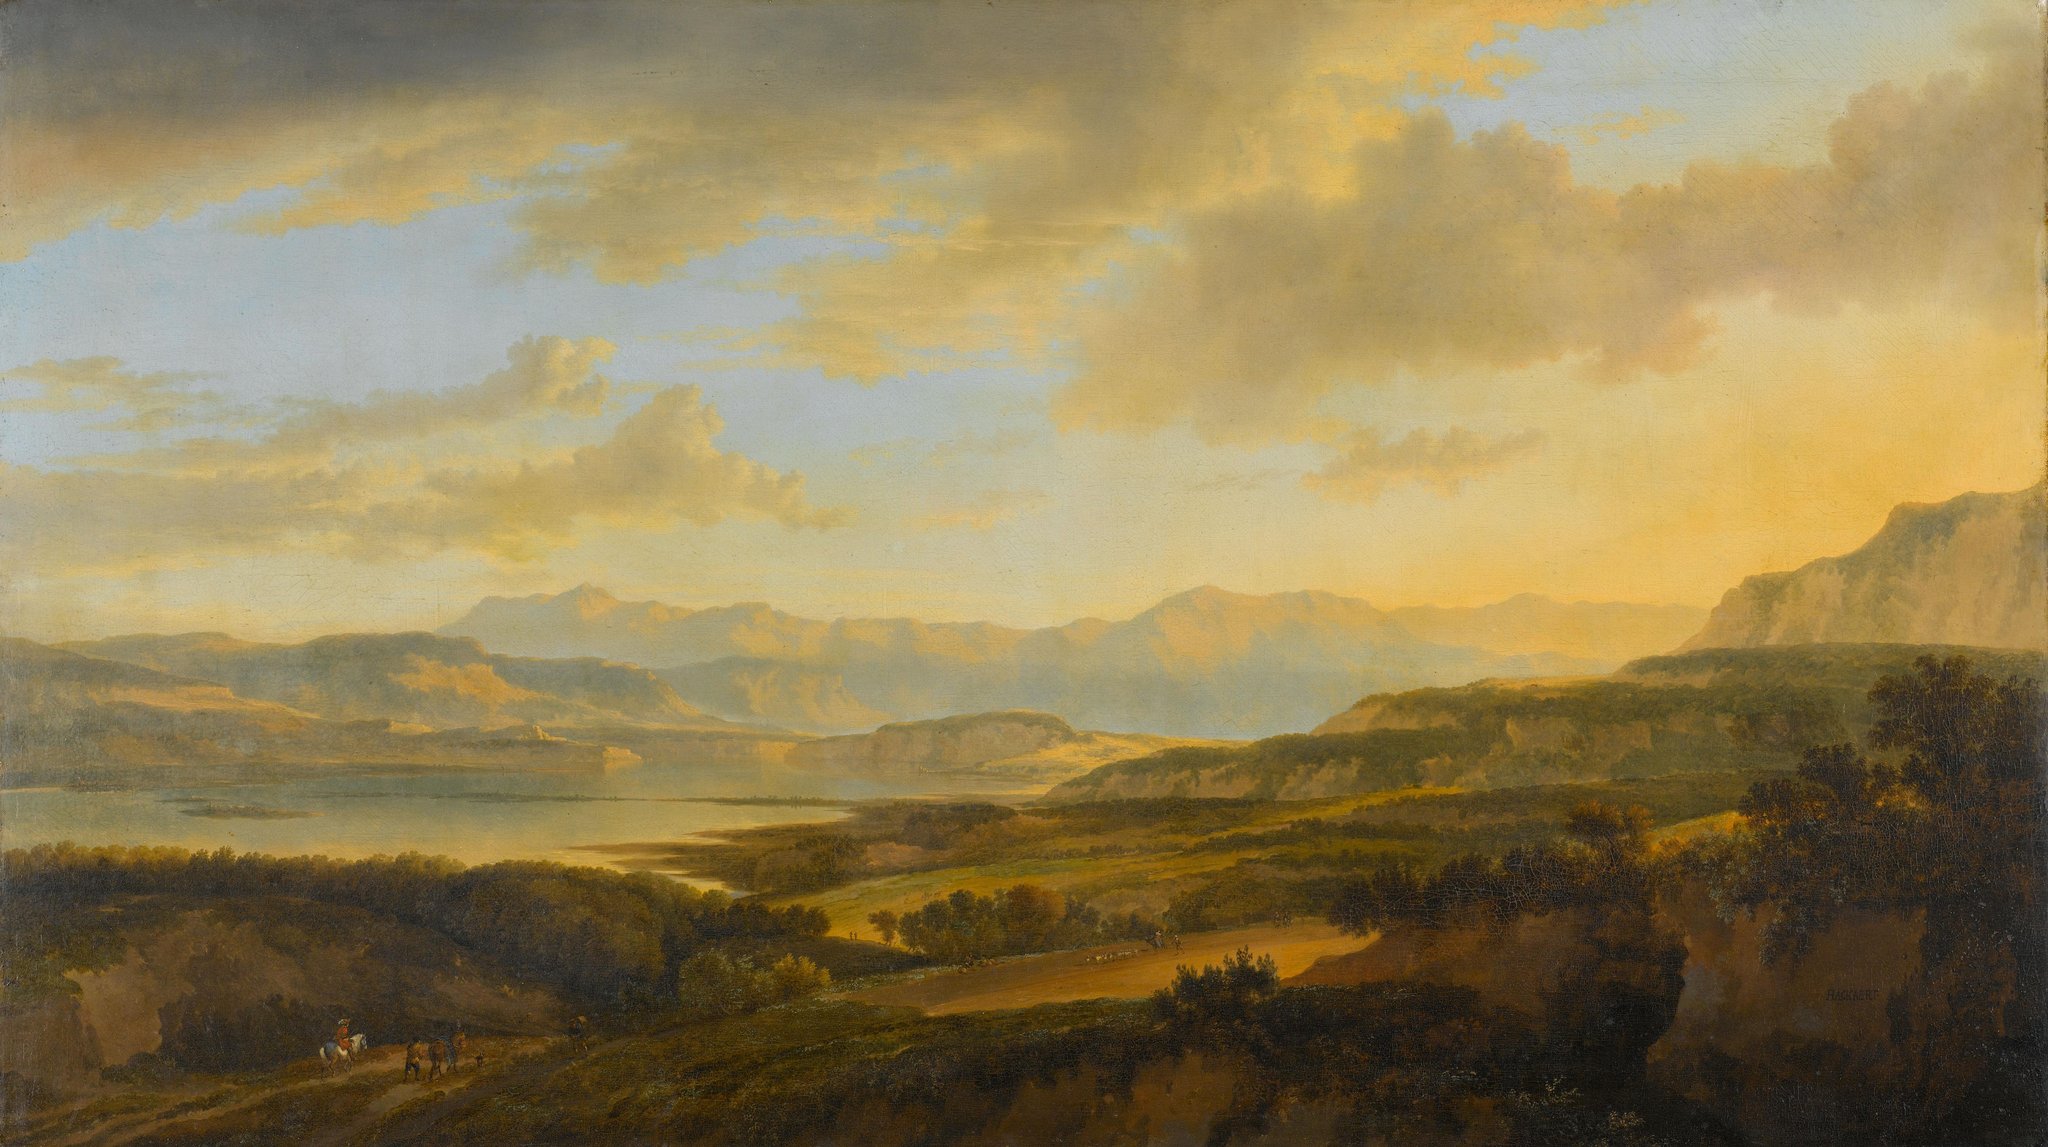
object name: painting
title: The Lake of Zurich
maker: jan hackaert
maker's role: draughtsman, painter, print maker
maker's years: 1628-1705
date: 1660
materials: canvas, oil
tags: lake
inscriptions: signature: ‘Hackaert.’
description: Hackaert belongs to the Dutch Italianates, the name given to painters able to capture the golden sunlight of Italy. It is unclear whether he ever actually travelled to Italy. What is certain is that he lived for many years in Switzerland, where he made drawings in the environs of Zurich. He relied on such studies for this panoramic view – it is one of the earliest topographical renderings of the Alps.